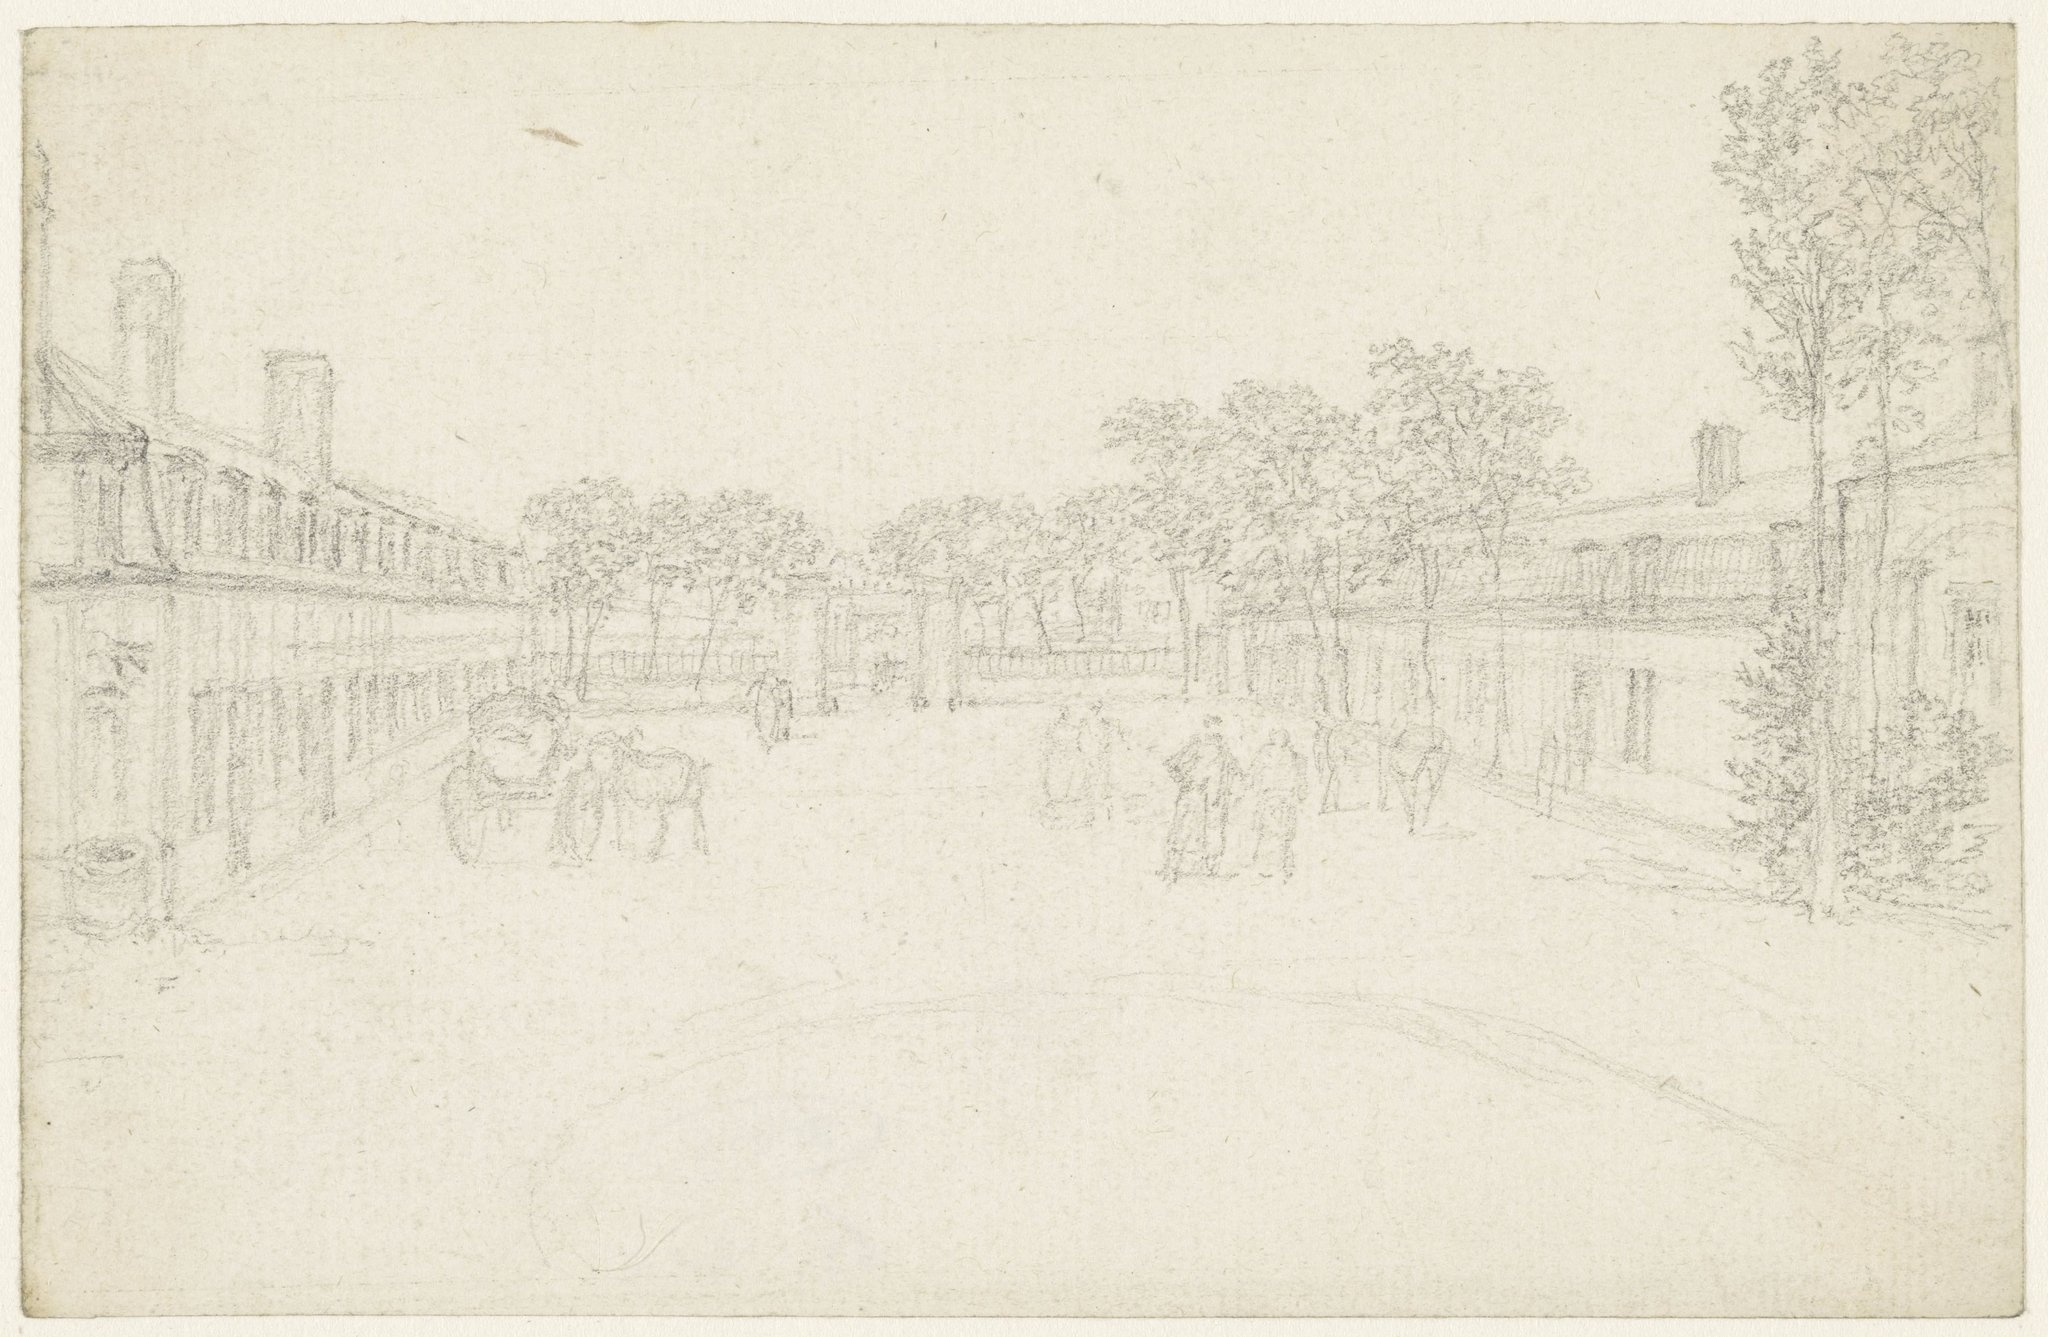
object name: drawing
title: Een cour tussen twee corps de logis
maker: georges michel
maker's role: draughtsman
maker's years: 1763-1843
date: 1773-1843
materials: paper, pencil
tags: courtyard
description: Een van 120 tekeningen, afkomstig uit een 19e eeuws album met tekeningen van Georges Michel.